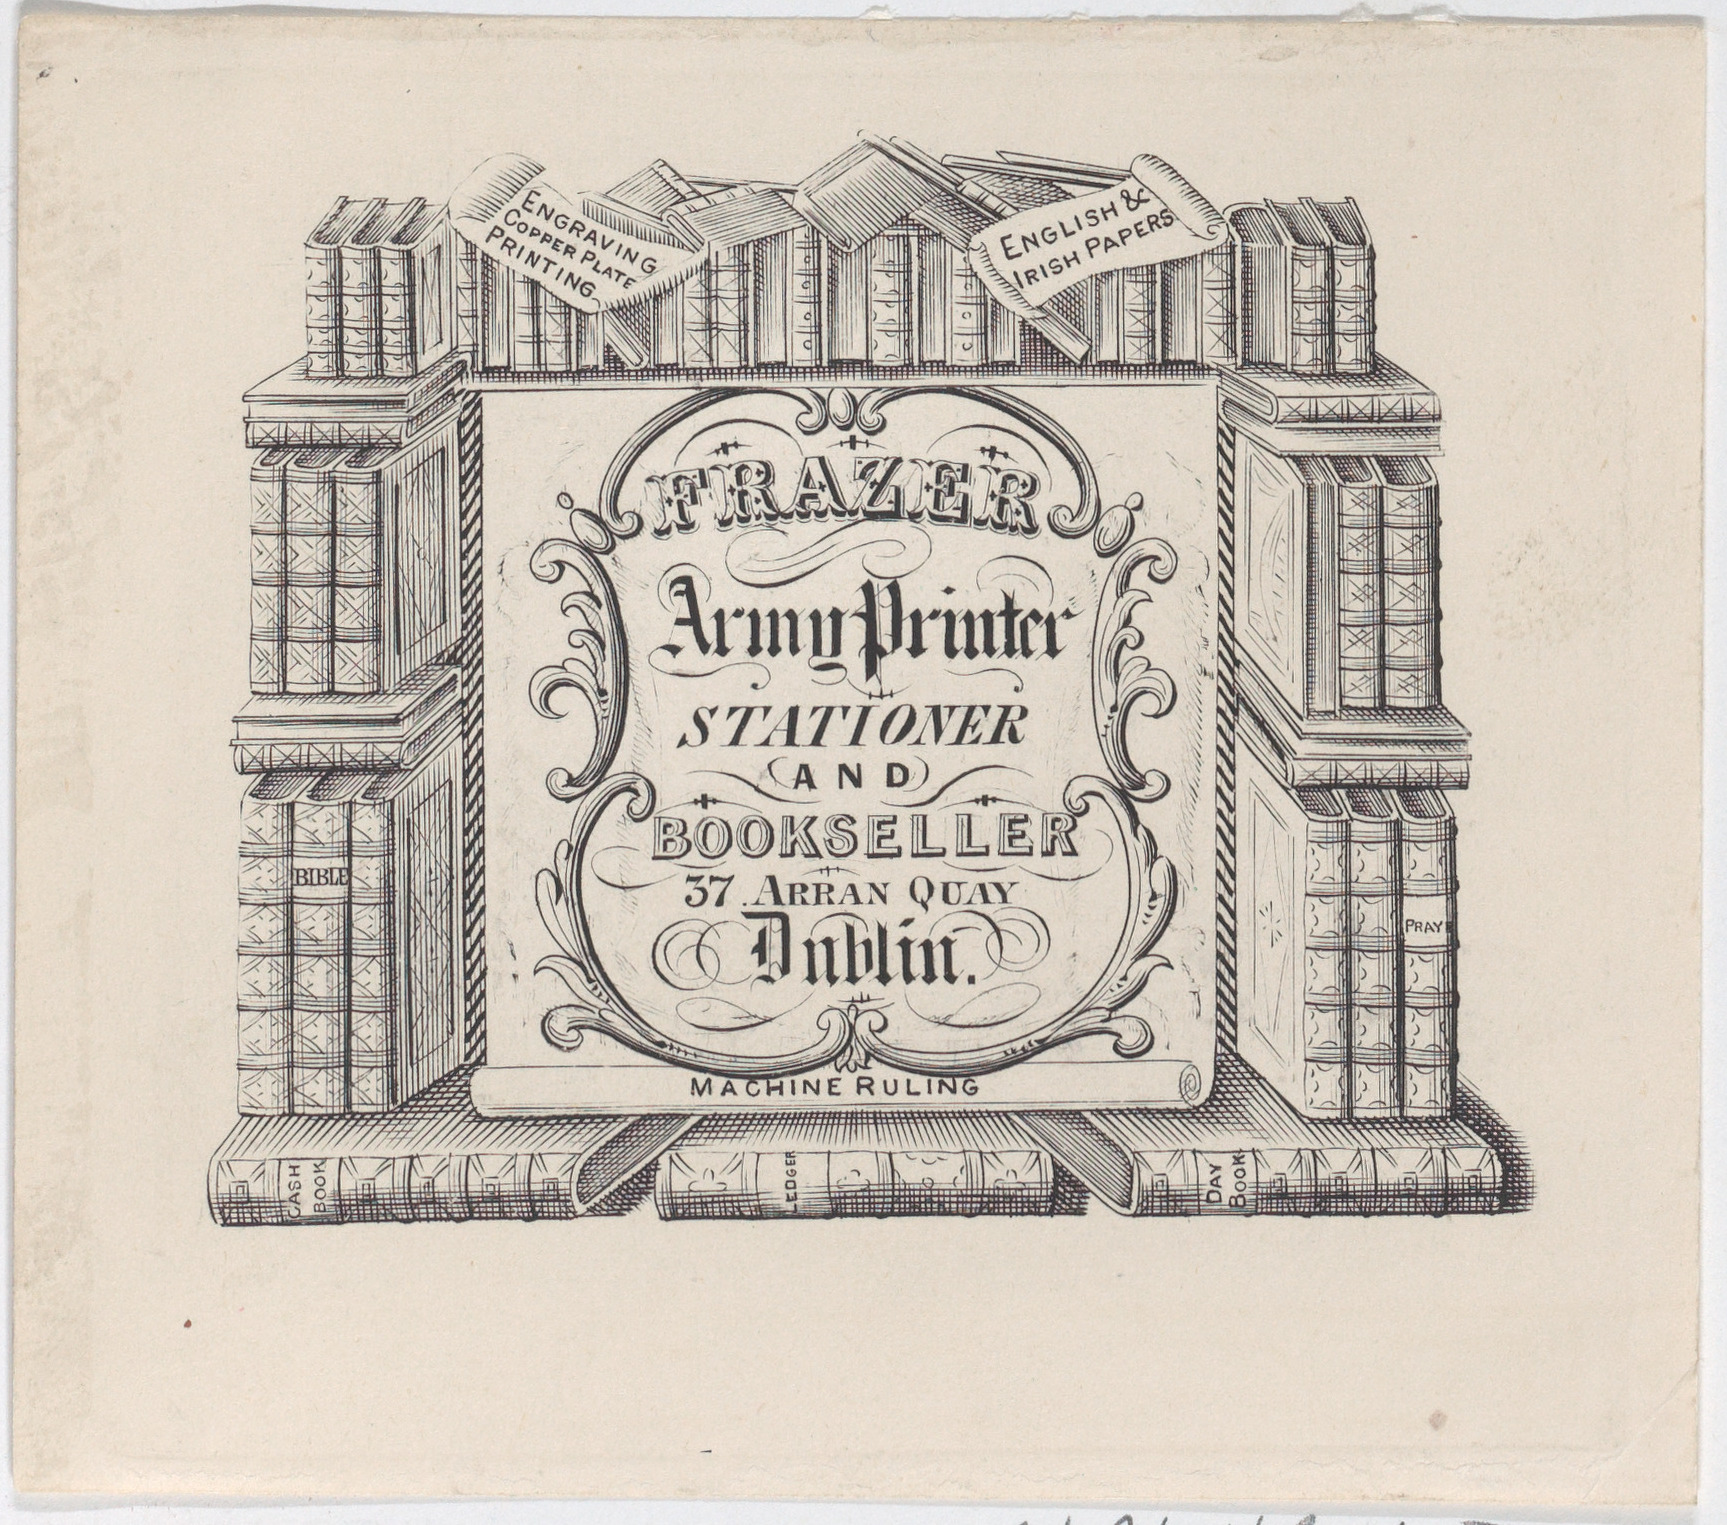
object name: print, trade card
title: Trade card for Frazer, Army Printer, Stationer and Bookbinder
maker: anonymous, irish, 19th century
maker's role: artist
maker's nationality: irish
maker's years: 1800-1900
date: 1801-1900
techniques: engraving